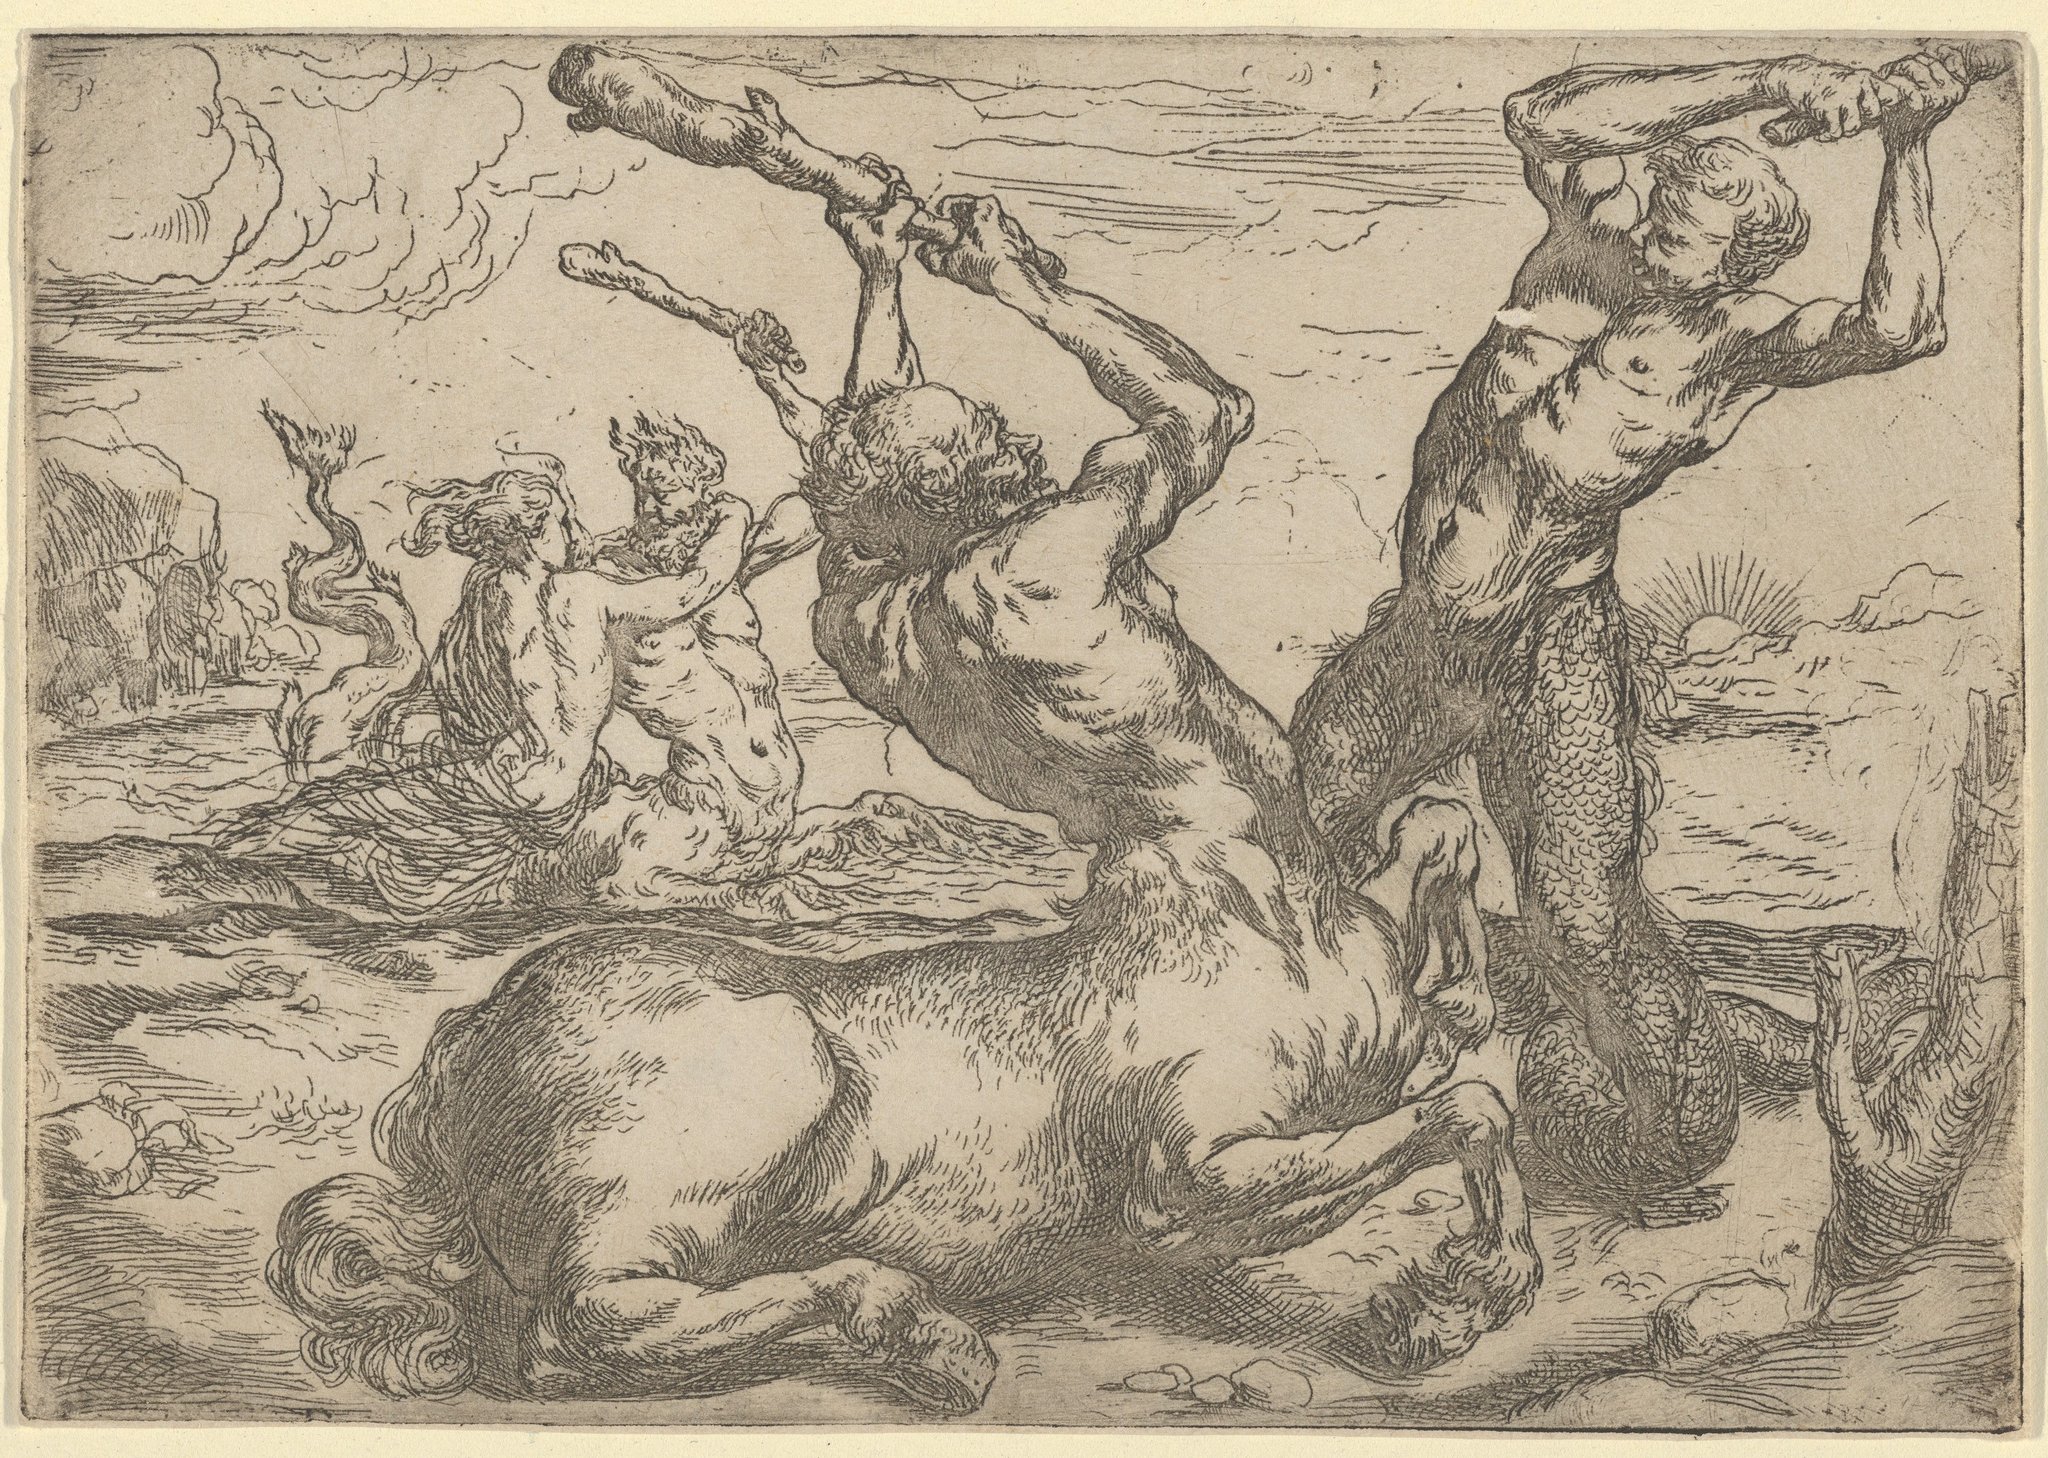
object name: print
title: Battle Between a Centaur and a Triton with a Triton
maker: jusepe de ribera (called lo spagnoletto)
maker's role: artist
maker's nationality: spanish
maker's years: 1591-1652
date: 1620-1640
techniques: etching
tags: battles,triton,centaurs